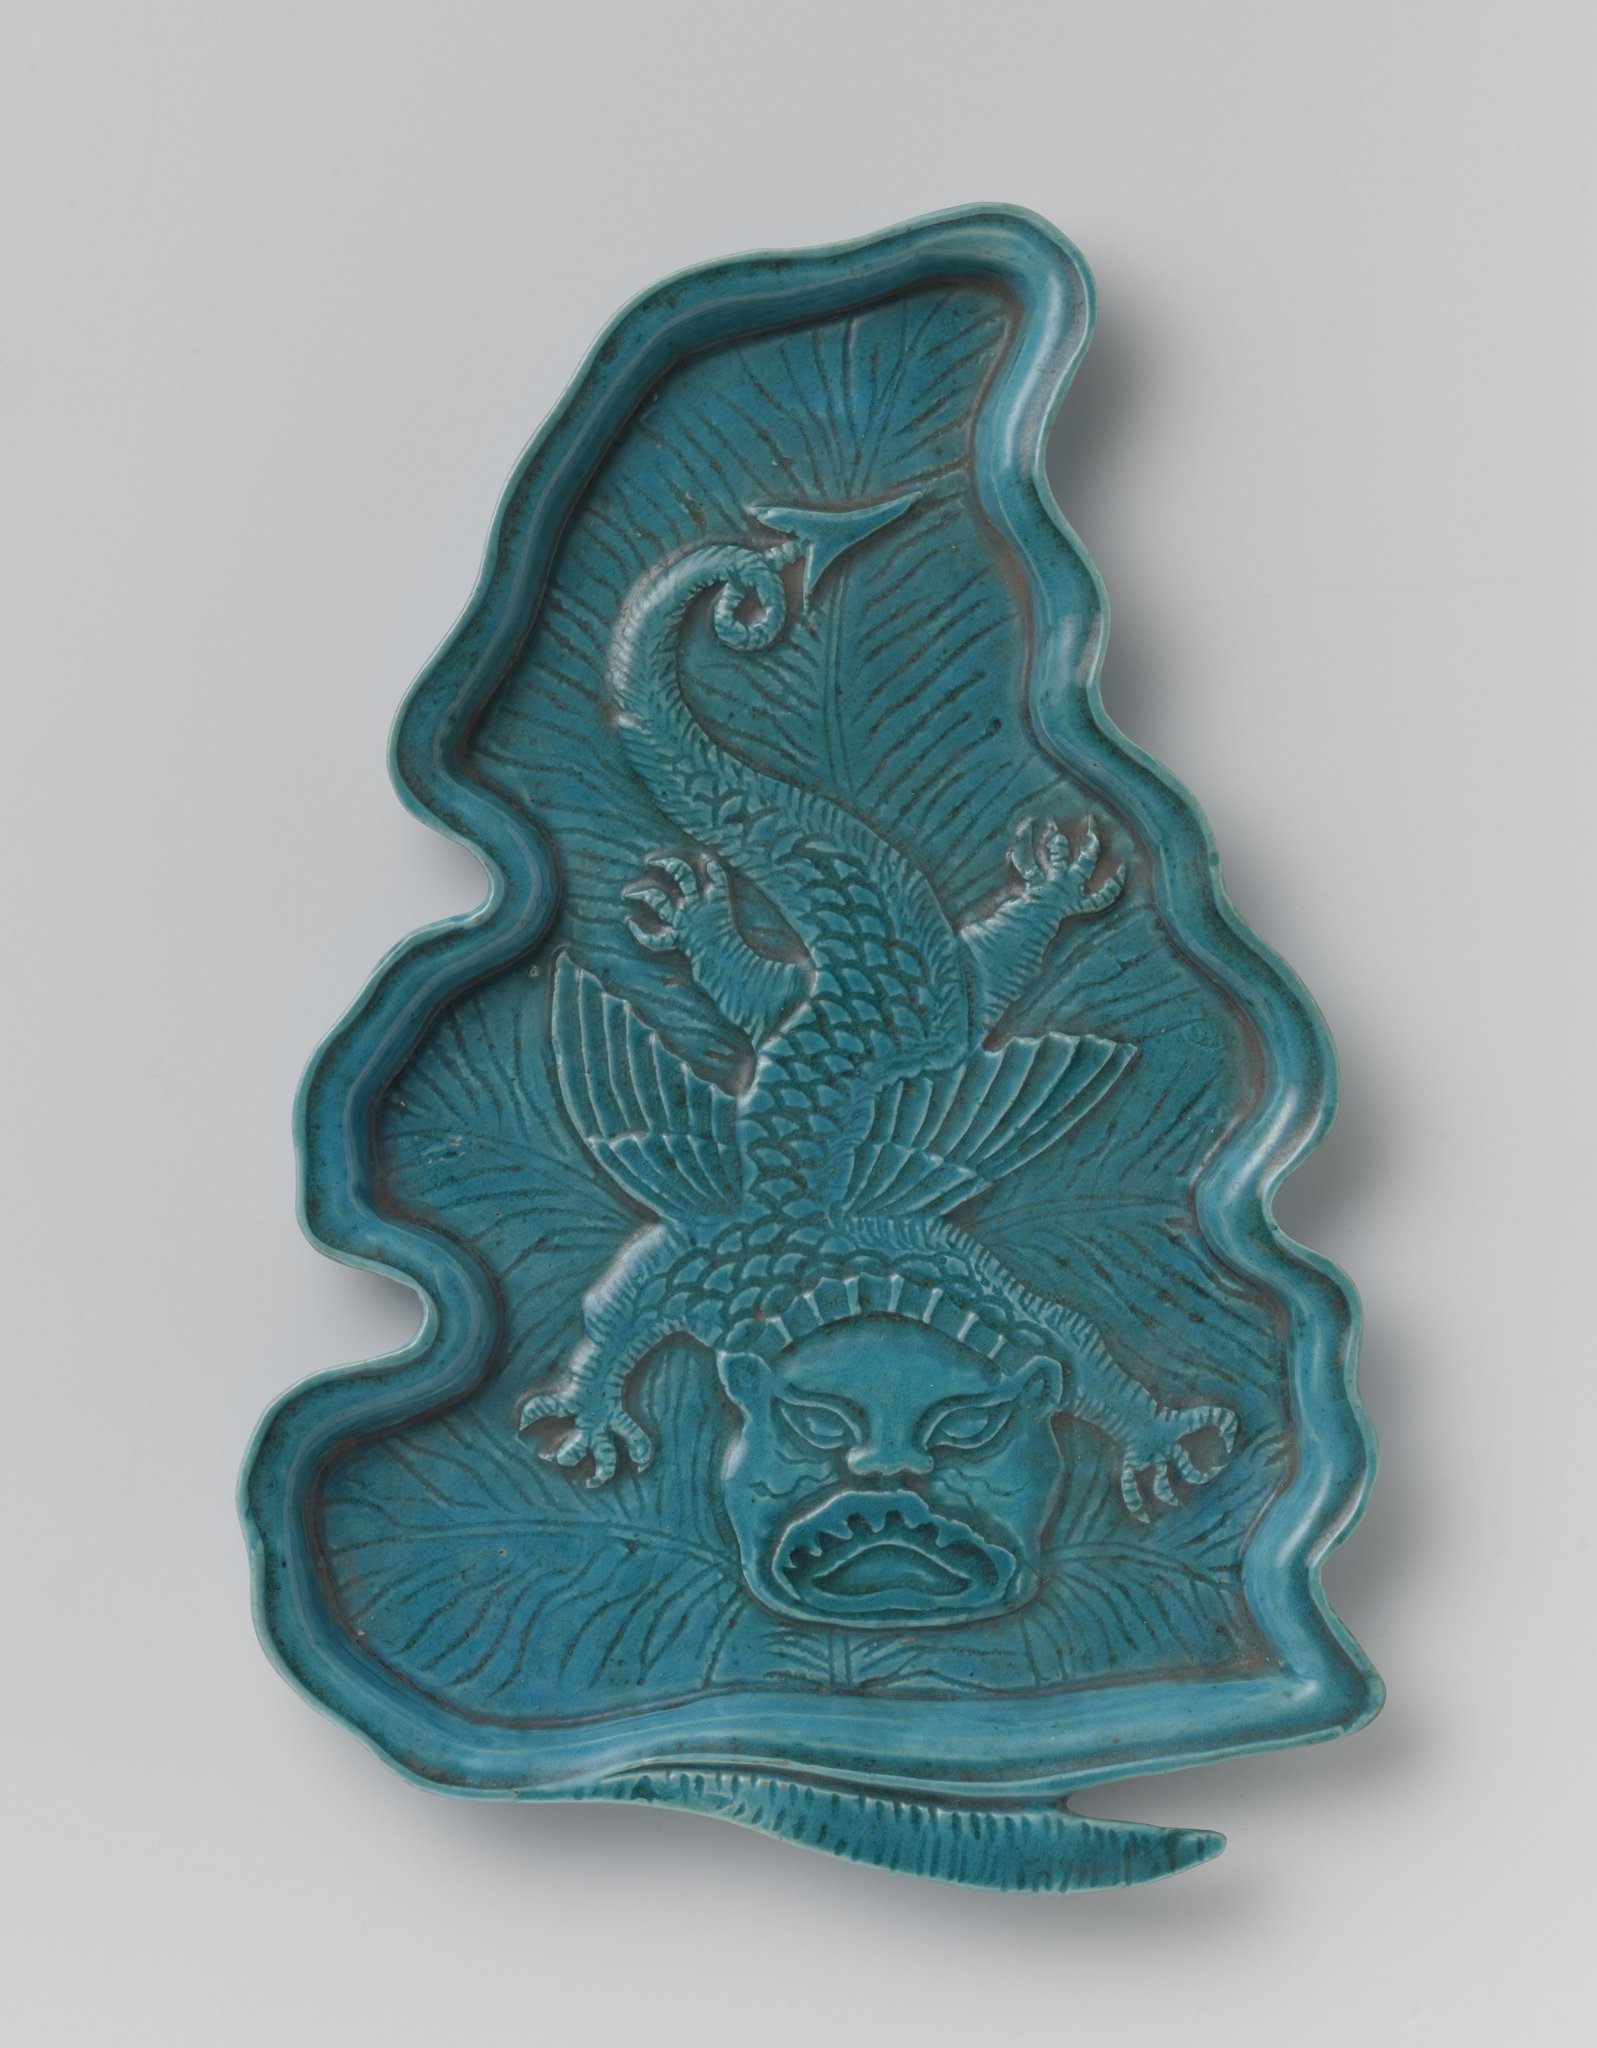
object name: covered bowl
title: Scallop-shaped covered bowl with a leaf-shaped stand with dragon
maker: Anonymous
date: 1775-1799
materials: glaze, porcelain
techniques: firing, forming, vitrification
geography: china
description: AK-NM-6432 Kom met deksel en (niet bijpassende) onderschotel • Gekleurd – monochroom porselein • Onderdeel van Royers porseleincollectie Omdat er wordt getwijfeld of de vaasjes AK-NM-7370 en 6371 wel 18de-eeuws zijn en tot Royers verzameling hebben behoord, is deze schelp eigenlijk het enige monochrome stuk porselein dat we – zonder tegenbericht – beschouwen als onderdeel van Royers collecties. Zoals ook bij de gecraqueleerde kleine vazen het geval was, zijn vergelijkbare schelpen bekend met uitvoerige Franse vergulde monturen uit het midden van de 18de eeuw [Lunsingh Scheurleer 1980, afb. 283 (Walters Gallery), Krahl 1996, vol. II, nr. 263 (Rothschild collectie)]. Zoals bekend waren monochromen geliefd in Frankrijk, en niet in Nederland. De Franse smaak voor porselein nam aan het eind van de 17de eeuw al een andere wending dan die in Nederland. Het ging in Frankrijk in het algemeen om kleinere aantallen stukken – vaak gemonteerd – die fraai combineerden met andere kostbaarheden in een collectie. Porselein sloot aan op hardstenen voorwerpen. Terwijl in Nederland de volle Marot-opstellingen nog lang na-ijlden, bestond in Frankrijk vaak al een grotere aandacht en kieskeurigheid voor afzonderlijke stukken. Dit komt naar voren in de manier waarop porselein in veilingcatalogi van vooraanstaande collecties beschreven wordt [Castelluccio 2013]. In de catalogus van de veiling van de collectie Randon de Boisset uit 1777 staat bijvoorbeeld: ‘par le ton doux & distingué de sa couleur… elle donne une variété brillant, étant artisement distribuée dans un cabinet.’ [Castelluccio 2013, p. 156 en cat. Randon de Bossiet 1777 (Lugtnr. 2652) vol. II, p. 74]. De voorliefde voor bleu céleste, de term die voor deze kleur blauw [maar ook voor het lichtere turkoois?] komt ook tot uitdrukking in de Sèvres schelpen, met precies deze vorm en een iets lichter maar toch zeer overeenkomstig glazuur. Deze Franse stukken kunnen gedateerd worden tussen 1763 en 1768 [Jarry 1981, pl. 125]. Voor de onderschotel heb ik geen vergelijkbare exemplaren in andere collecties kunnen vinden. De gedachtegang ‘dit is zo lelijk, dus het moet wel 19de-eeuws zijn’ is aanlokkelijk, maar de vreemde monsters zijn ook te vinden op een dekselpot met dit glazuur, voorzien van een Frans montuur uit het midden van de 18de eeuw [Jarry 1981, pl. 230]. Deze Franse manier van verzamelen was slechts van geringe betekenis voor de porseleinappreciatie in Nederland. Maar het lijkt me sterk dat het geheel onbekend was. Een zeer belangrijke porseleincollectie uit deze tijd, die van de gebroeders Bisschop (geveild 1771) lijkt deels gemodelleerd naar Frans voorbeeld. Natuurlijk keek men naar Franrijk, het internationale ijkpunt van de goede smaak! Ik ga er daarom vanuit dat ook Royer op de hoogte was van deze Franse smaak voor Chinees (en Japans) porselein en dat dat een stimulans kan zijn geweest deze schelp aan zijn collectie toe te voegen. Bronnen: Daniel François Lunsingh Scheurleer, Chinesisches und japanisches Porzellan in europäischen Fassungen, Braunschweig, 1980. Madeleine Jarry, Chinoiseries: le rayonnement du goût chinois sur les arts décoratifs des XVIIe et XVIIIe siècles, Fribourg, 1981. Regina Krahl, The Anthony de Rothschild collection of Chinese ceramics, Londen, 1996. Stephane Castelluccio, Collecting Chinese and Japanese porcelain in pre-revolutionary Paris, Los Angeles, 2013.